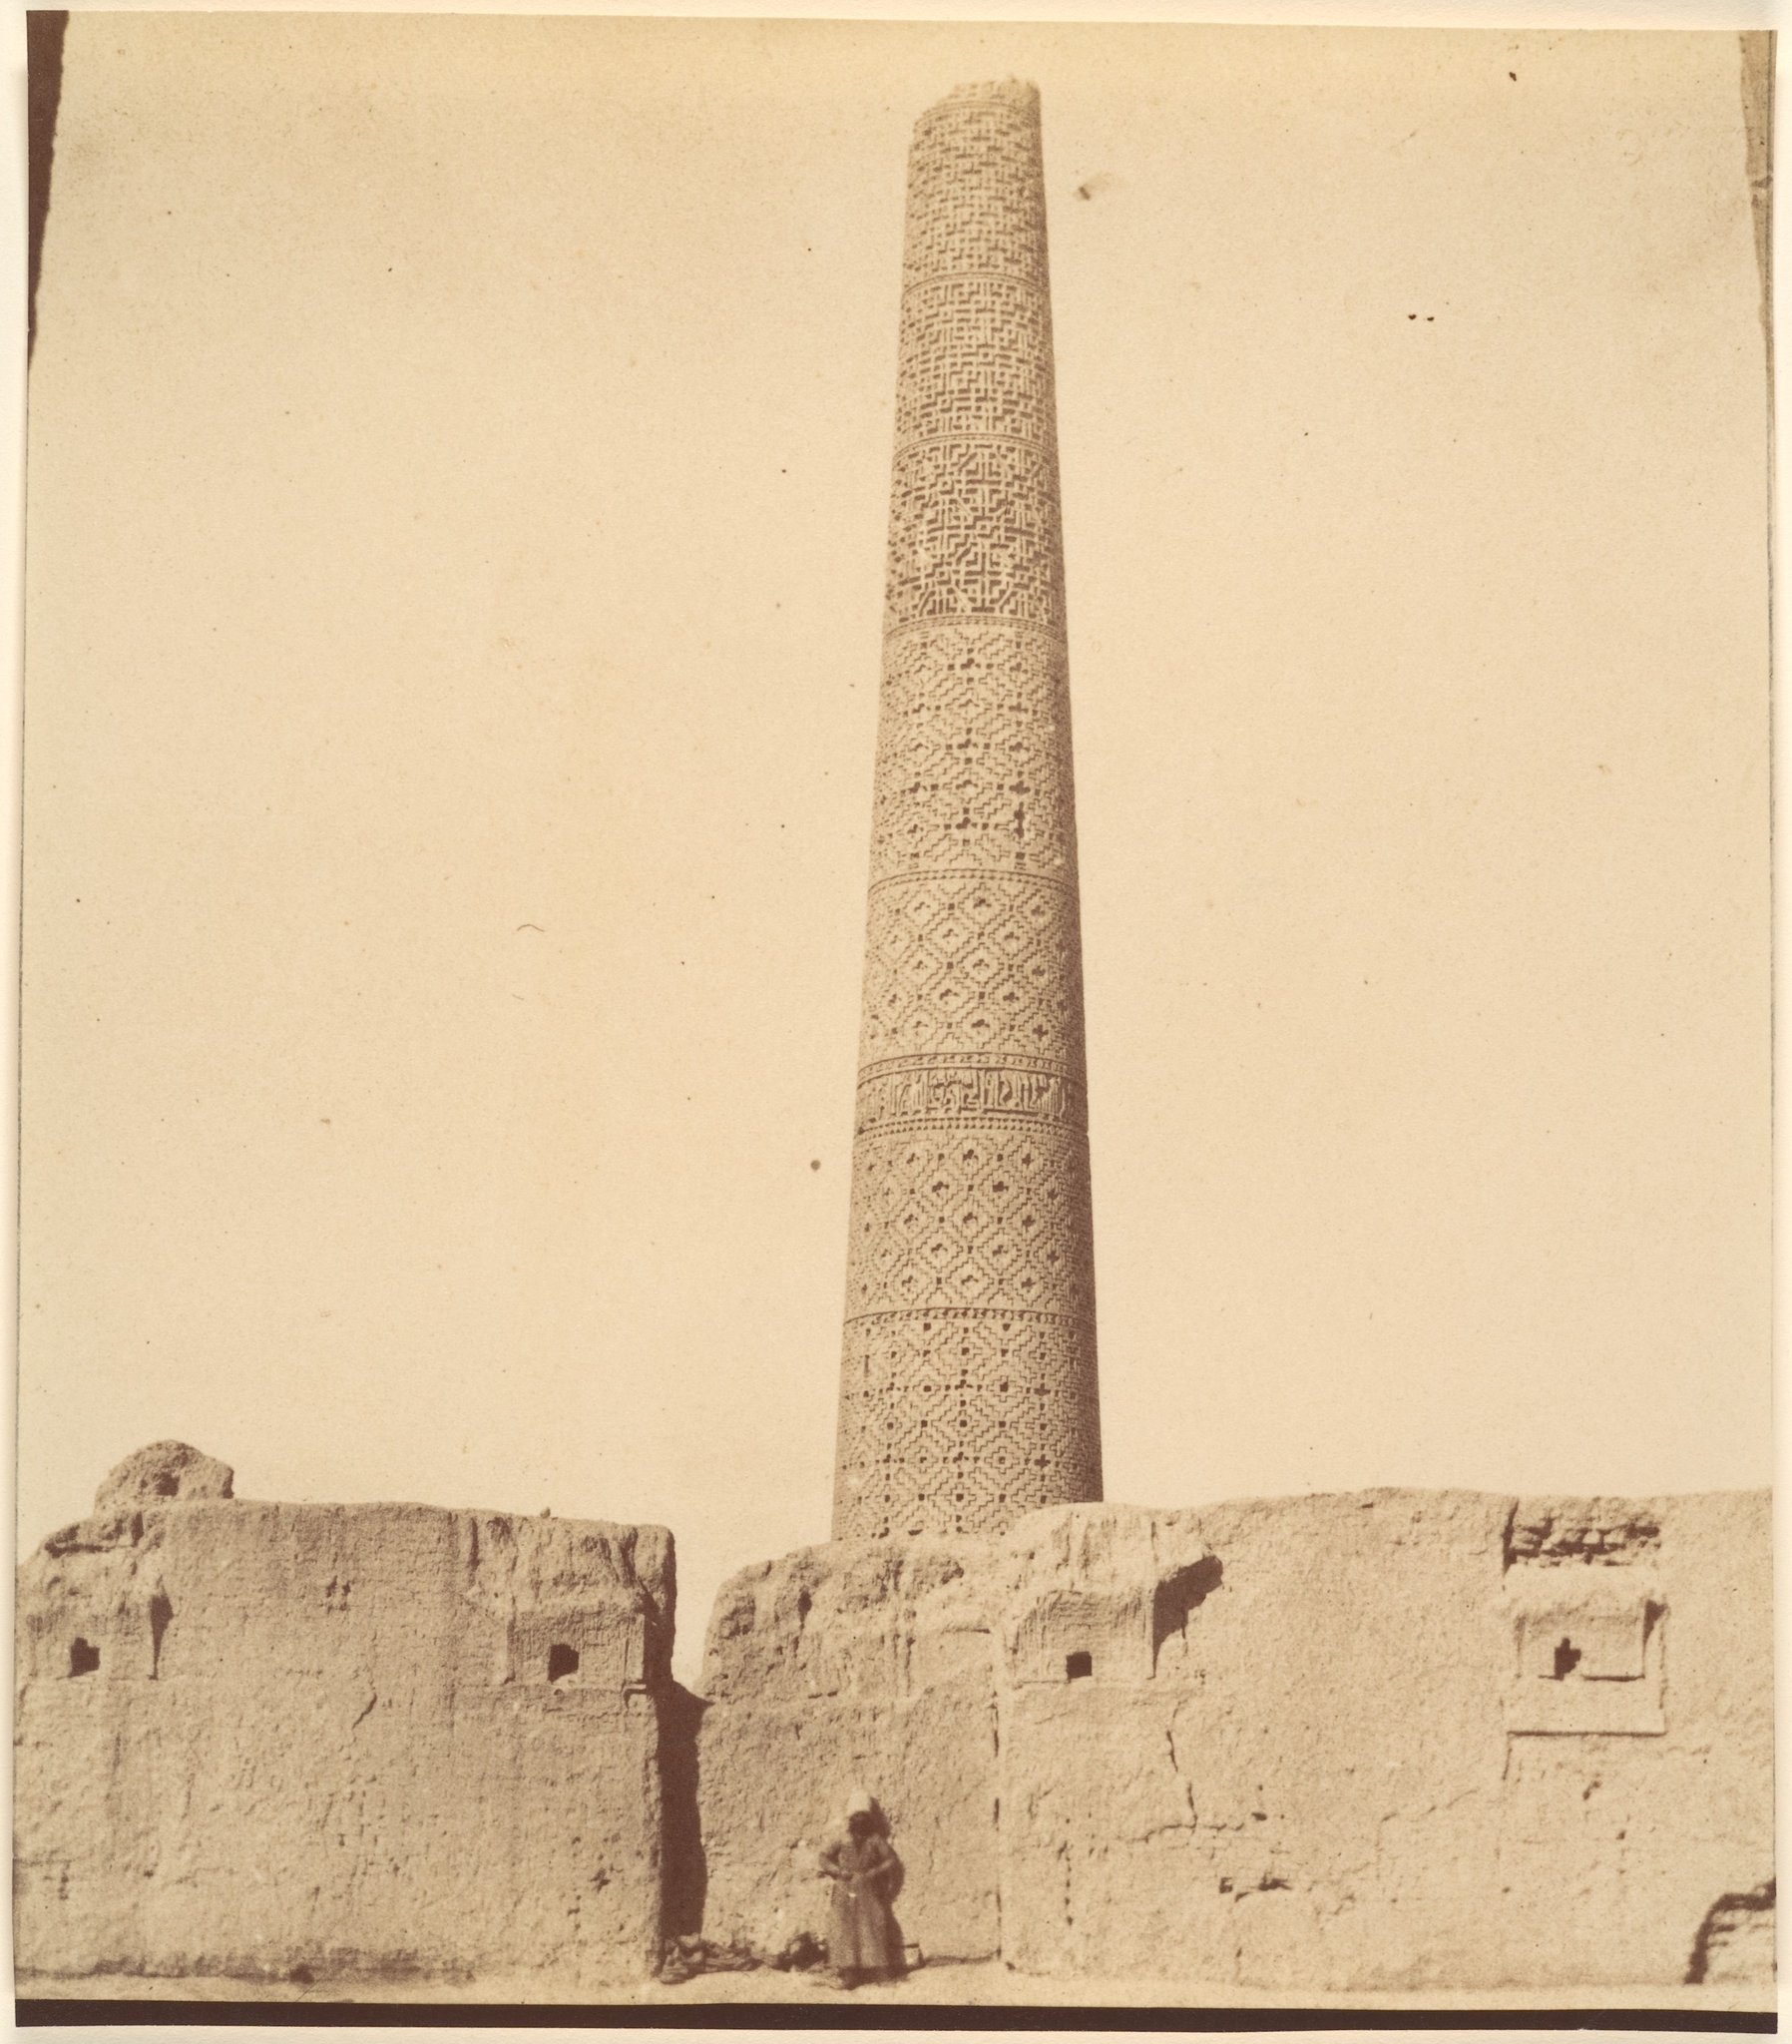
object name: photograph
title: [Minaret of the Mosque of 40 Columns, Chehel Dokhtar, 359b.]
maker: luigi pesce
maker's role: artist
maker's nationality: italian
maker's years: 1818-1891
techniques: albumen silver print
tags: architecture,mosques